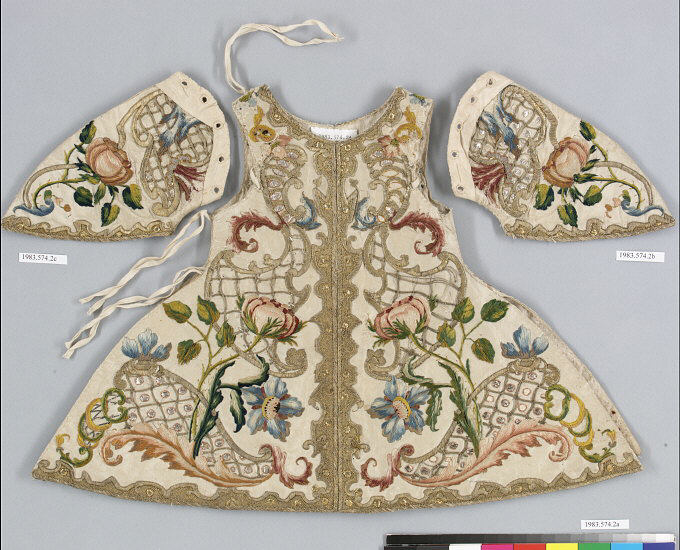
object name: statue robe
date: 1701-1800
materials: linen, metal thread, silk